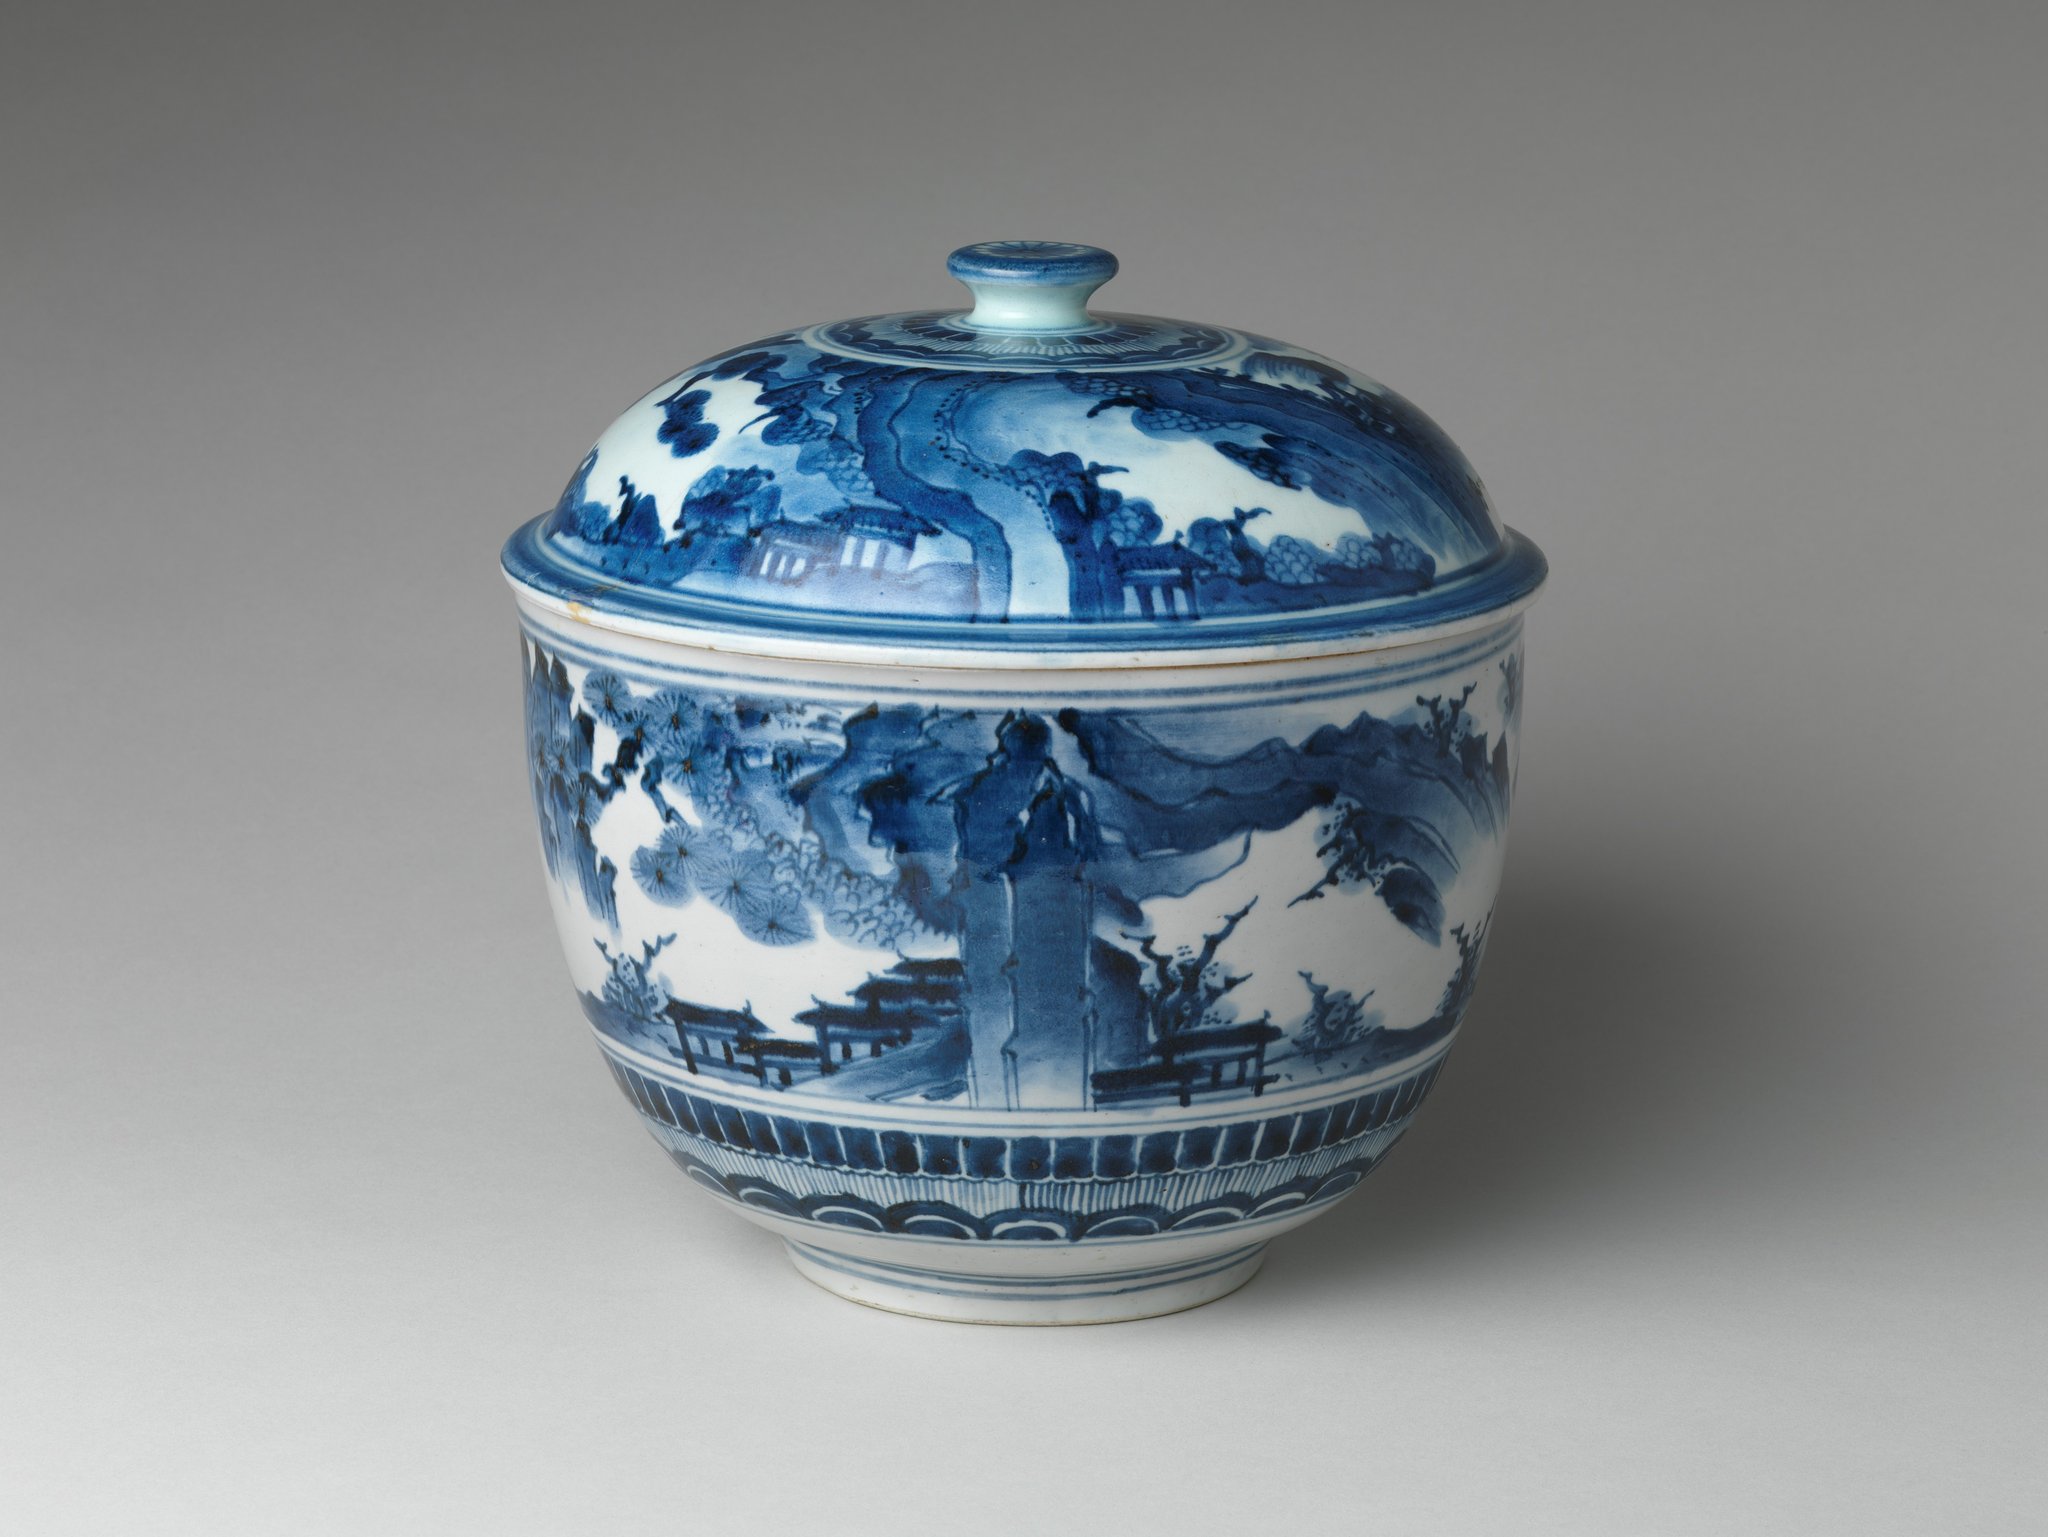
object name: tureen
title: Tureen with Landscape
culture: japanese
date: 1667-1700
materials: cobalt, glaze, porcelain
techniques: painting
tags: landscapes